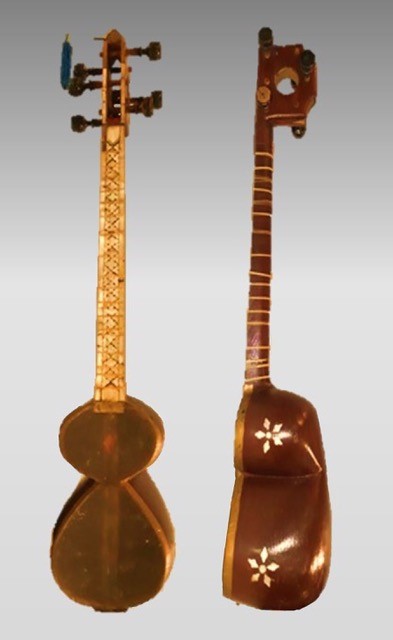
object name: tar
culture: armenian or georgian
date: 1867-1900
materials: metal, mother of pearl, skin, wood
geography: georgia